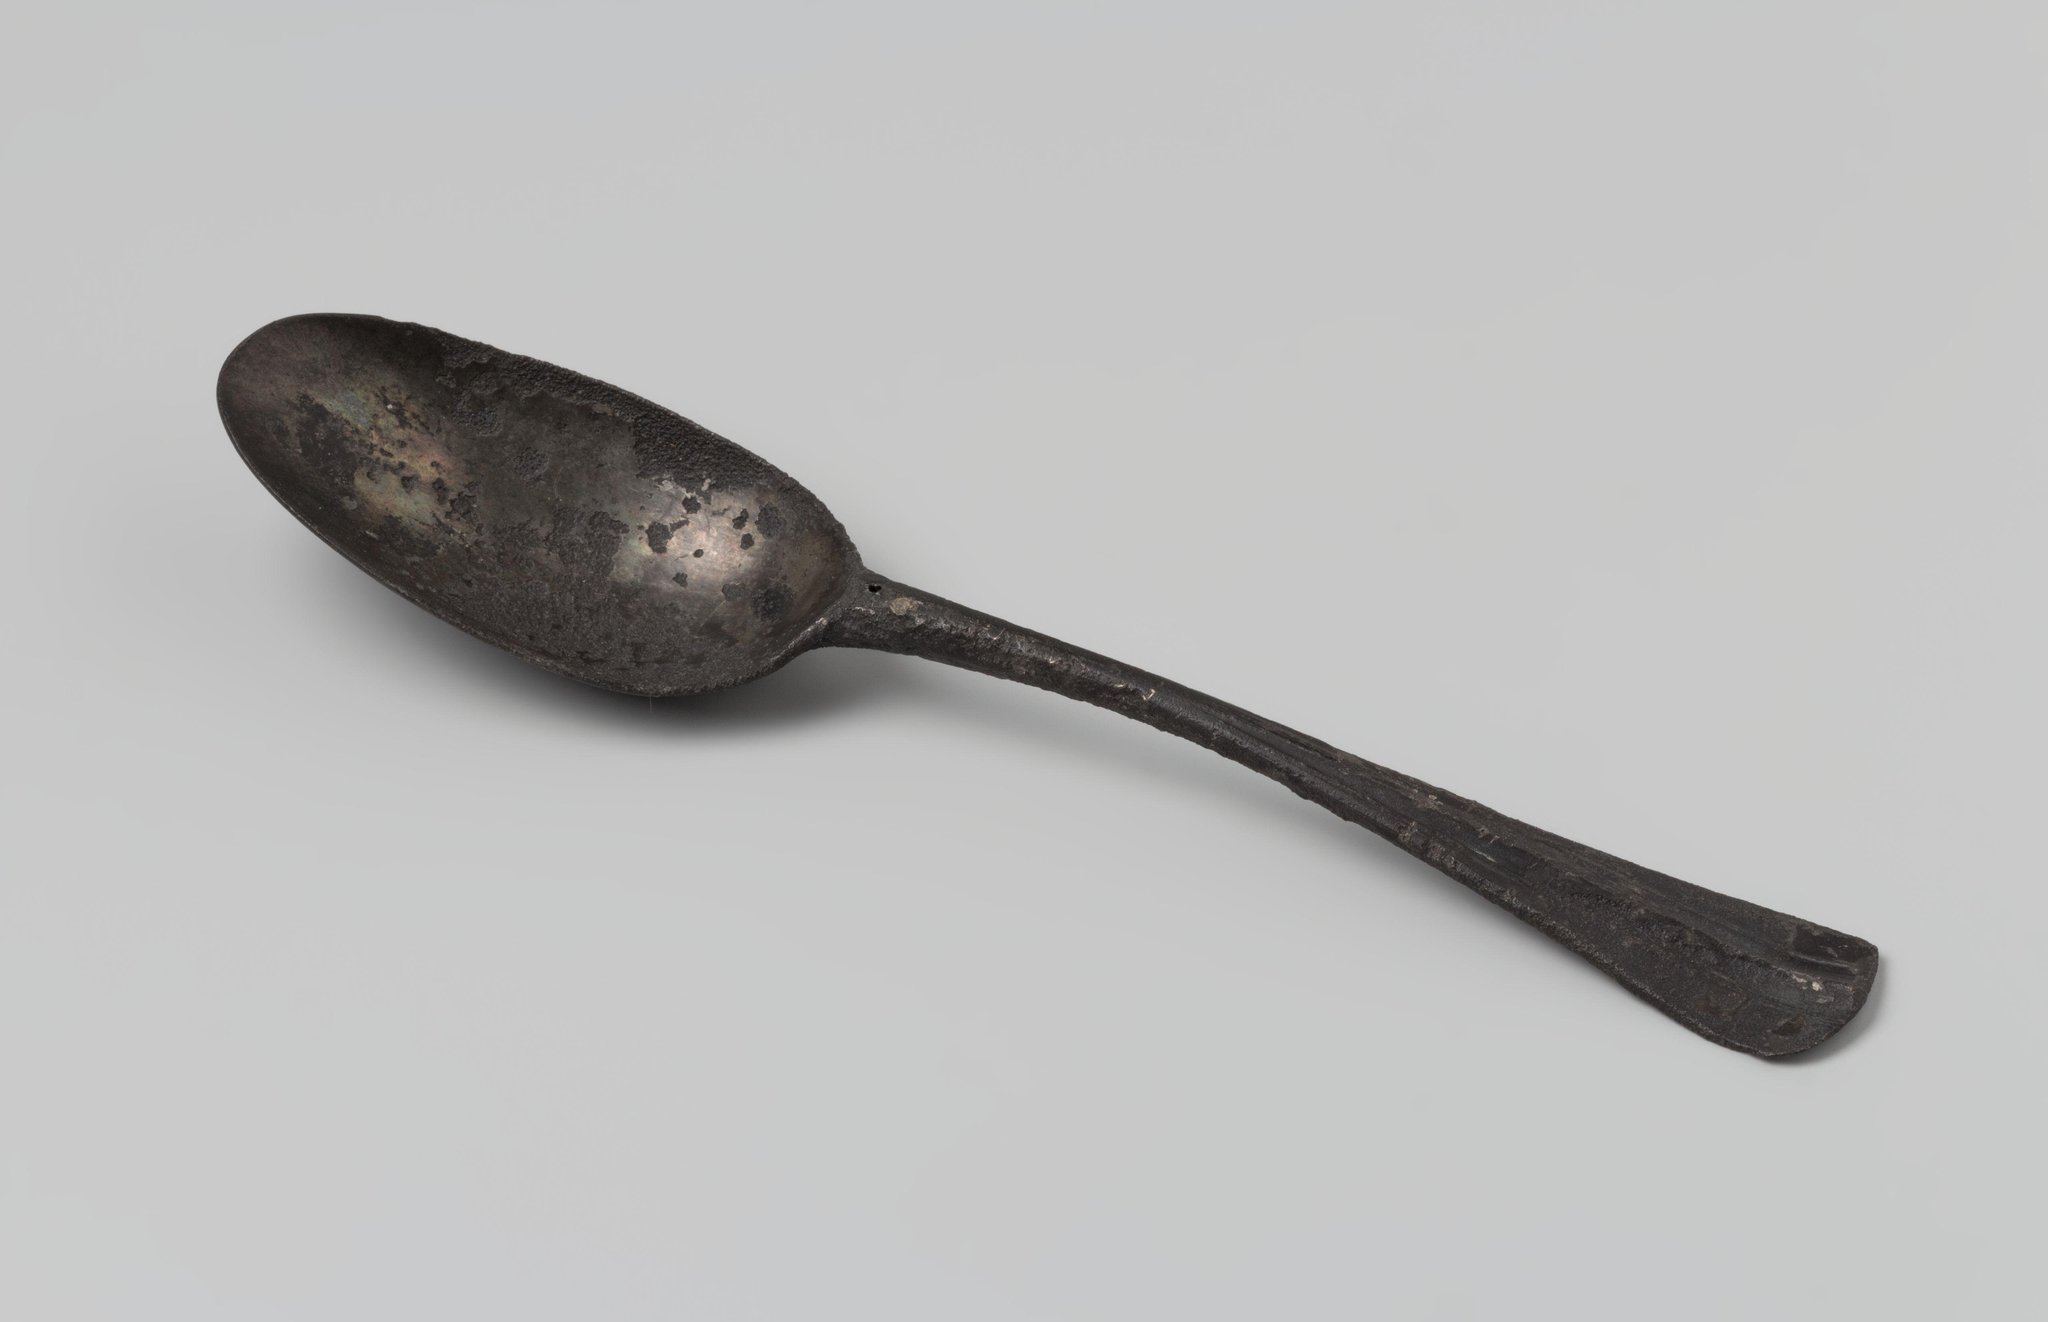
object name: spoon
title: Lepel uit het wrak van de Oost-Indiëvaarder 't Vliegend Hart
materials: tin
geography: middelburg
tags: 't vliegend hart (schip), verenigde oostindische compagnie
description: Tinnen lepel zonder merk, met profilering die in het zeewater zwart is geworden.